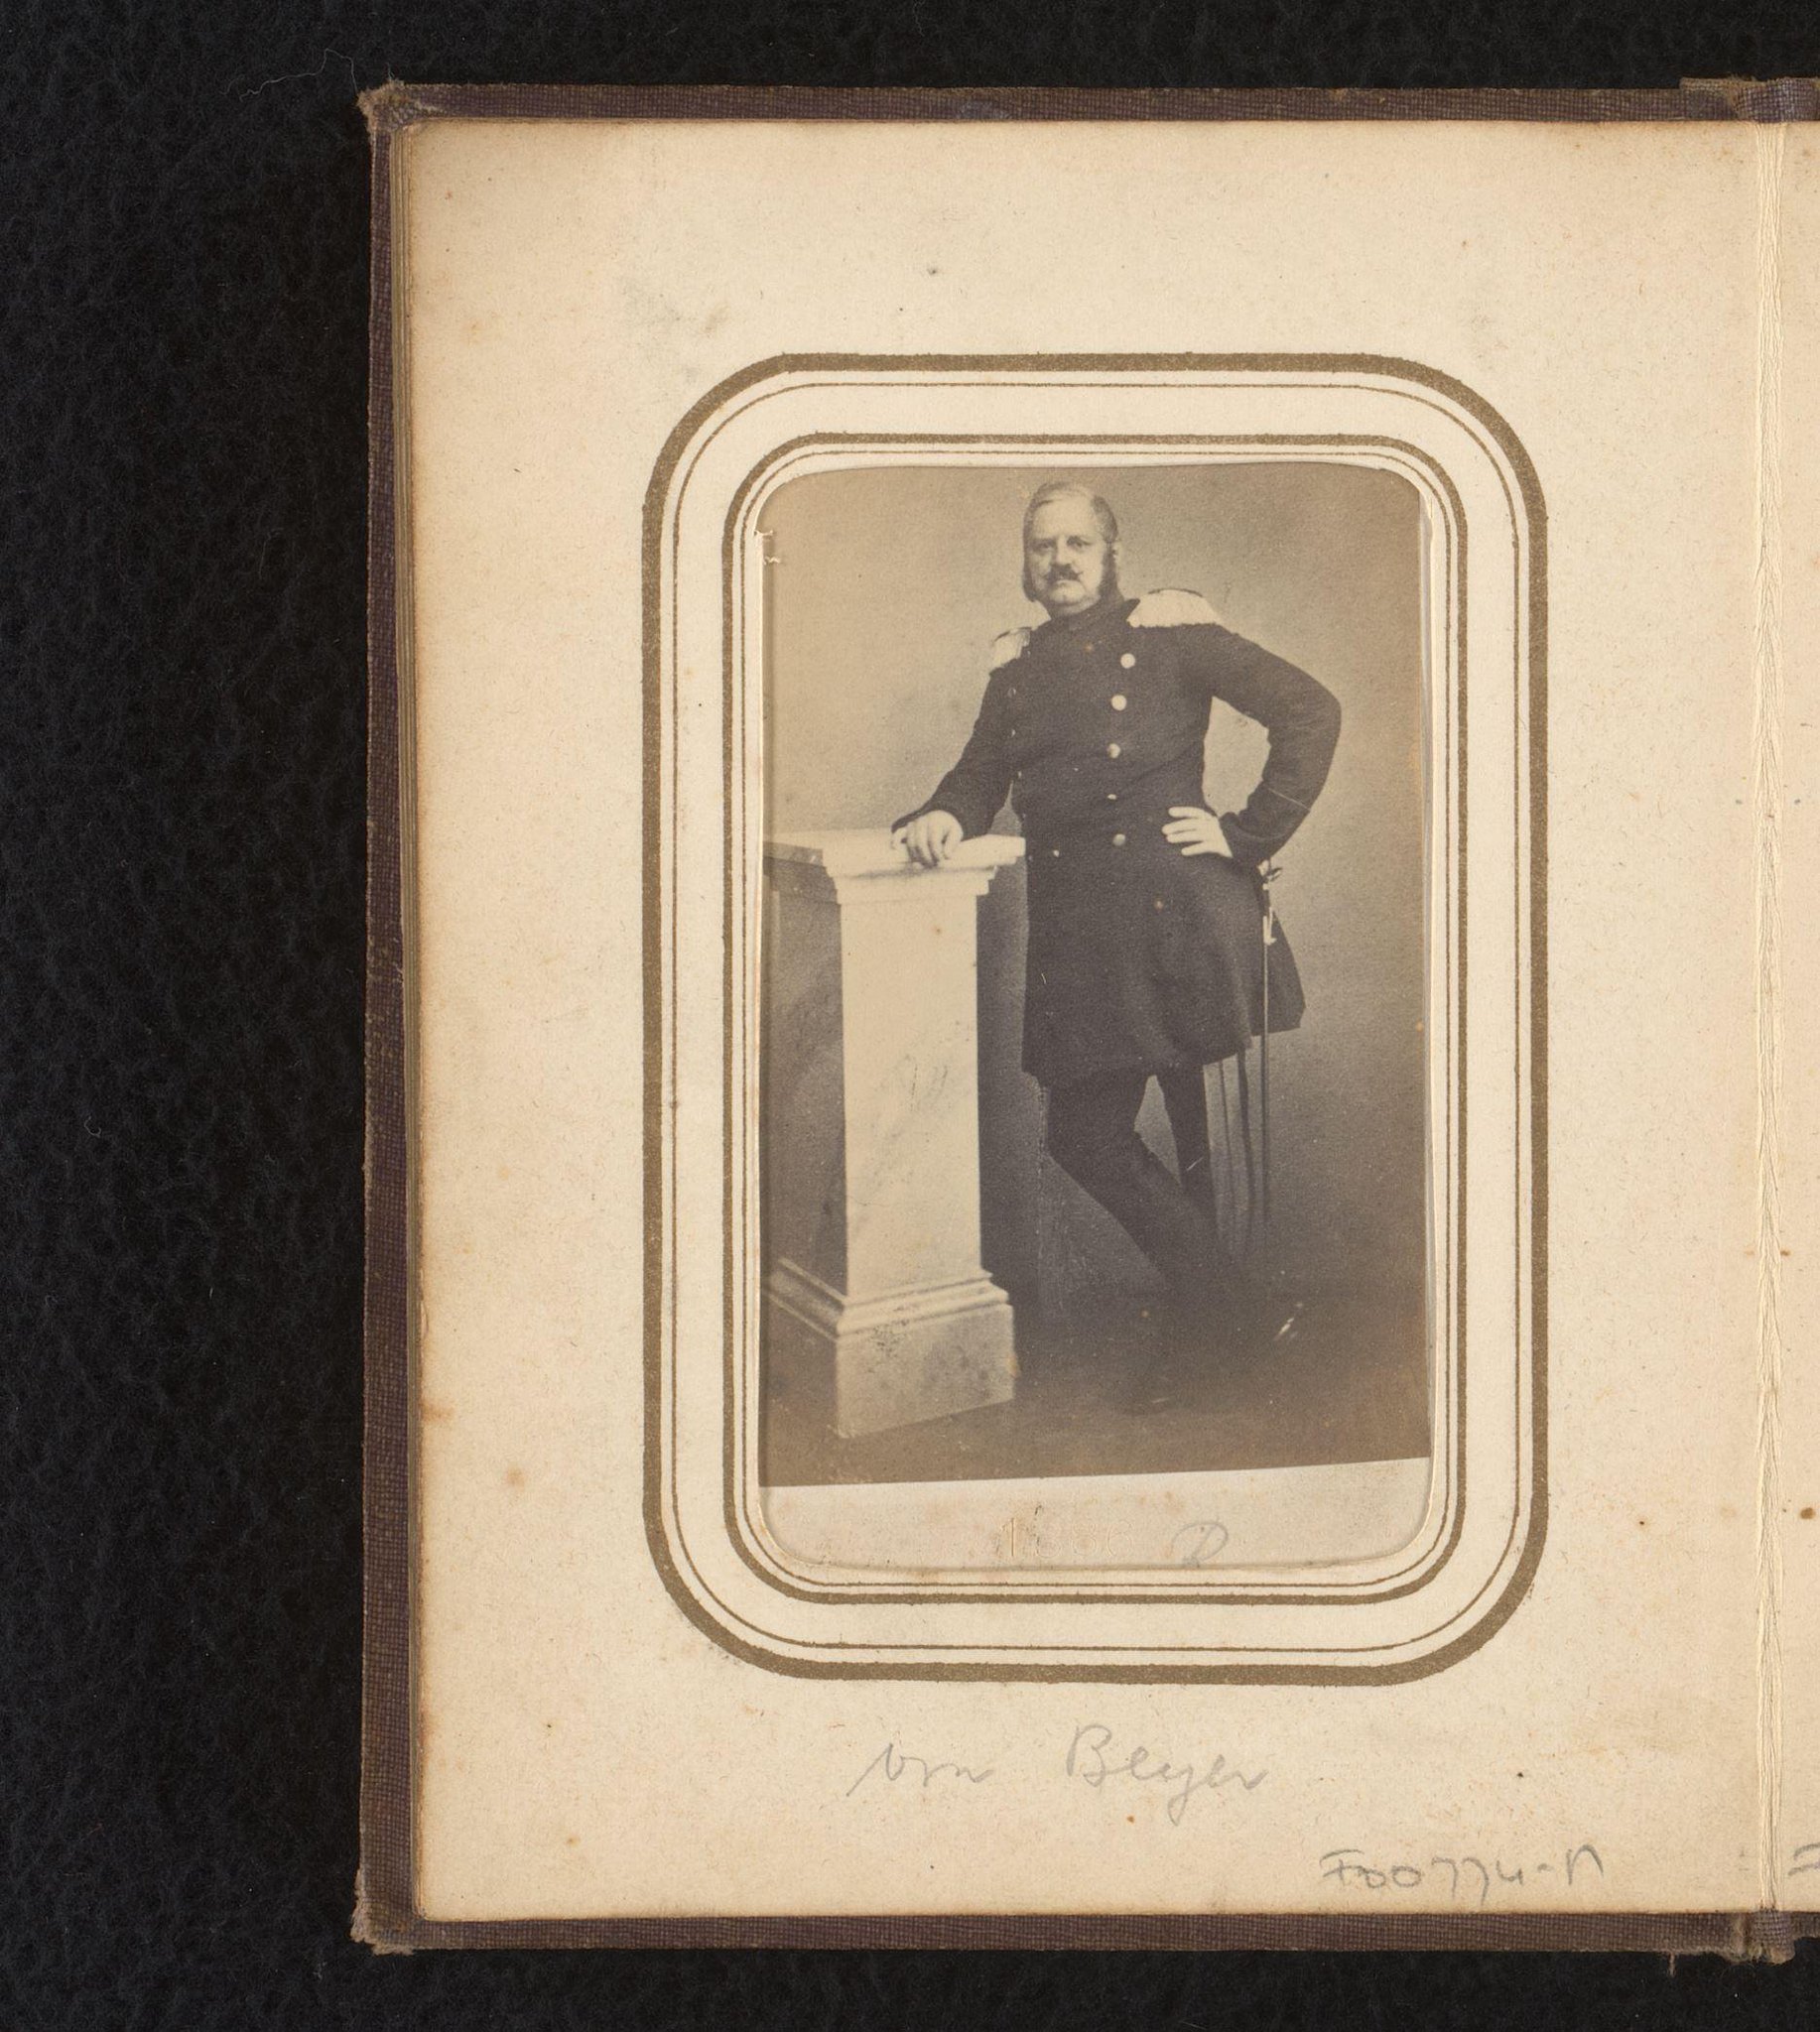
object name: photograph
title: Portret van Gustav Friedrich von Beyer in uniform bij een sokkel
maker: Anonymous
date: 1865-1889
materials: cardboard, photographic support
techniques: albumen print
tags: berlin, historical persons, pedestal of a piece of sculpture (perhaps in the form of a herm), (military) uniforms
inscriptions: number: ‘1886’, name: ‘von Beyer’, annotation: ‘von Beyer’